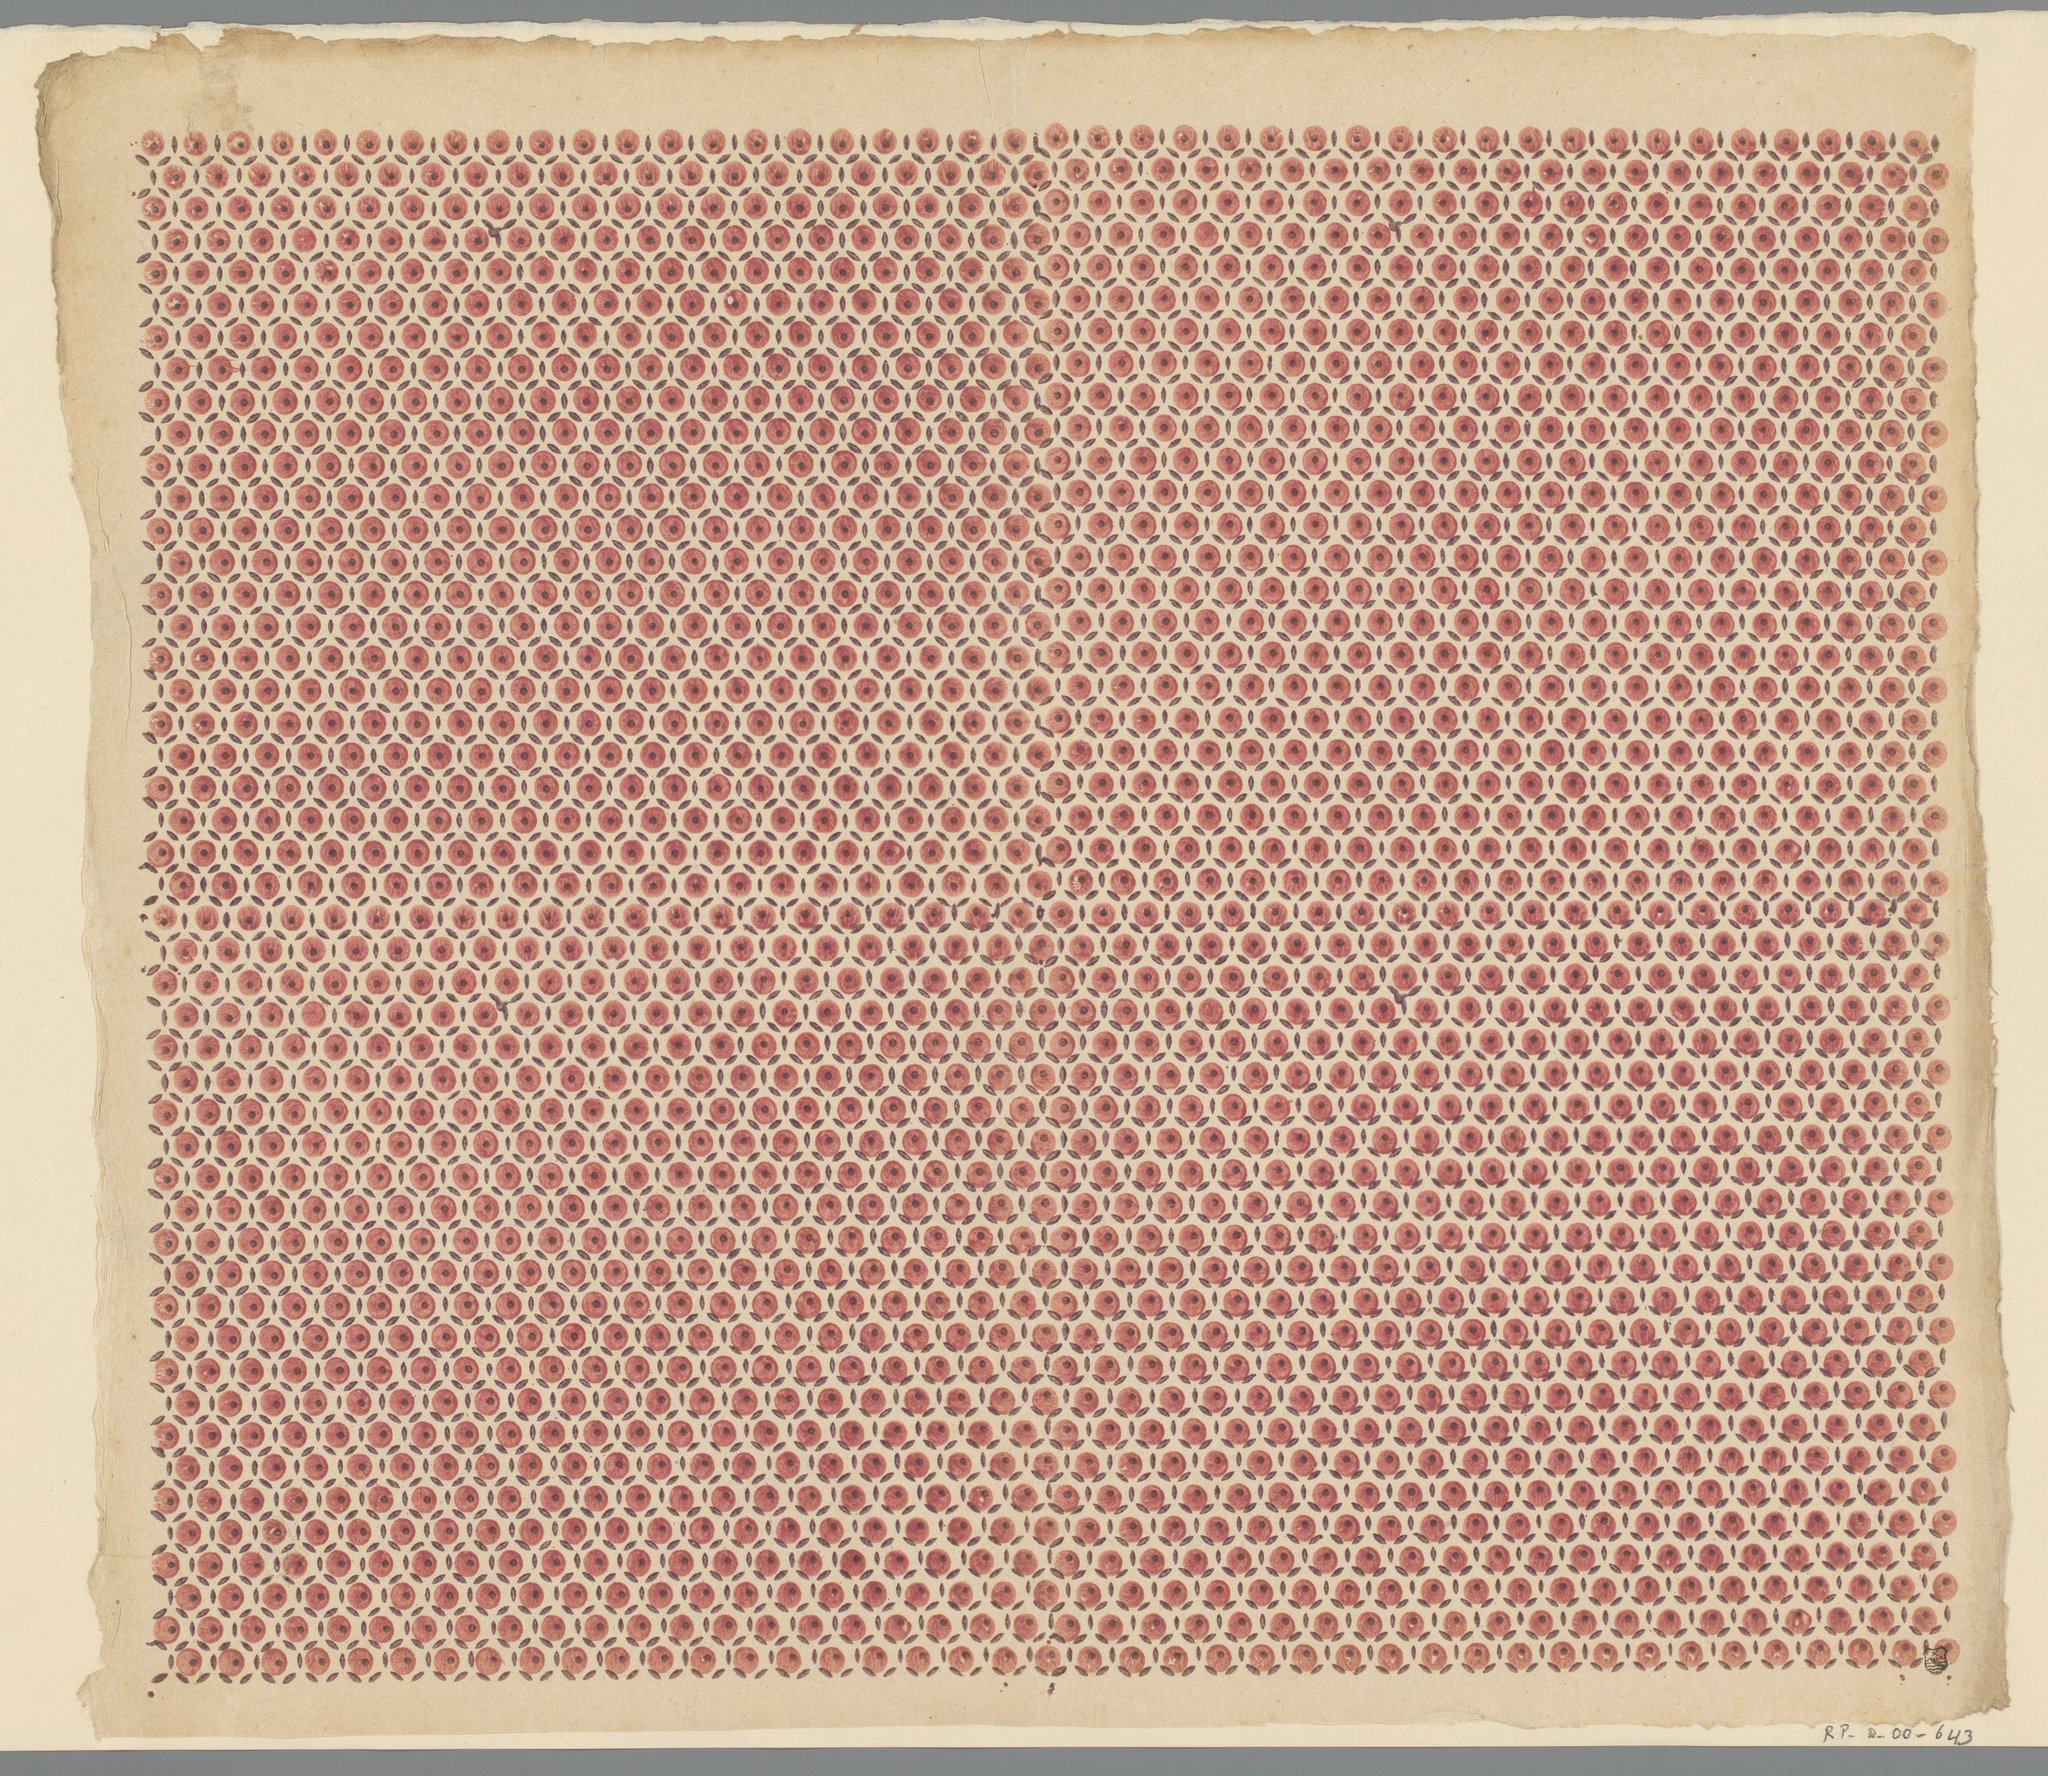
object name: printed paper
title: Blad met strooipatroon van vrucht tussen blaadjes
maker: Anonymous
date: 1750-1900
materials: paper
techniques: printing block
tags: ornament ~ round and curved forms, ornament derived from plant forms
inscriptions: collector's mark: Lugt 2760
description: Blad met strooipatroon van bol of vrucht tussen blaadjes.